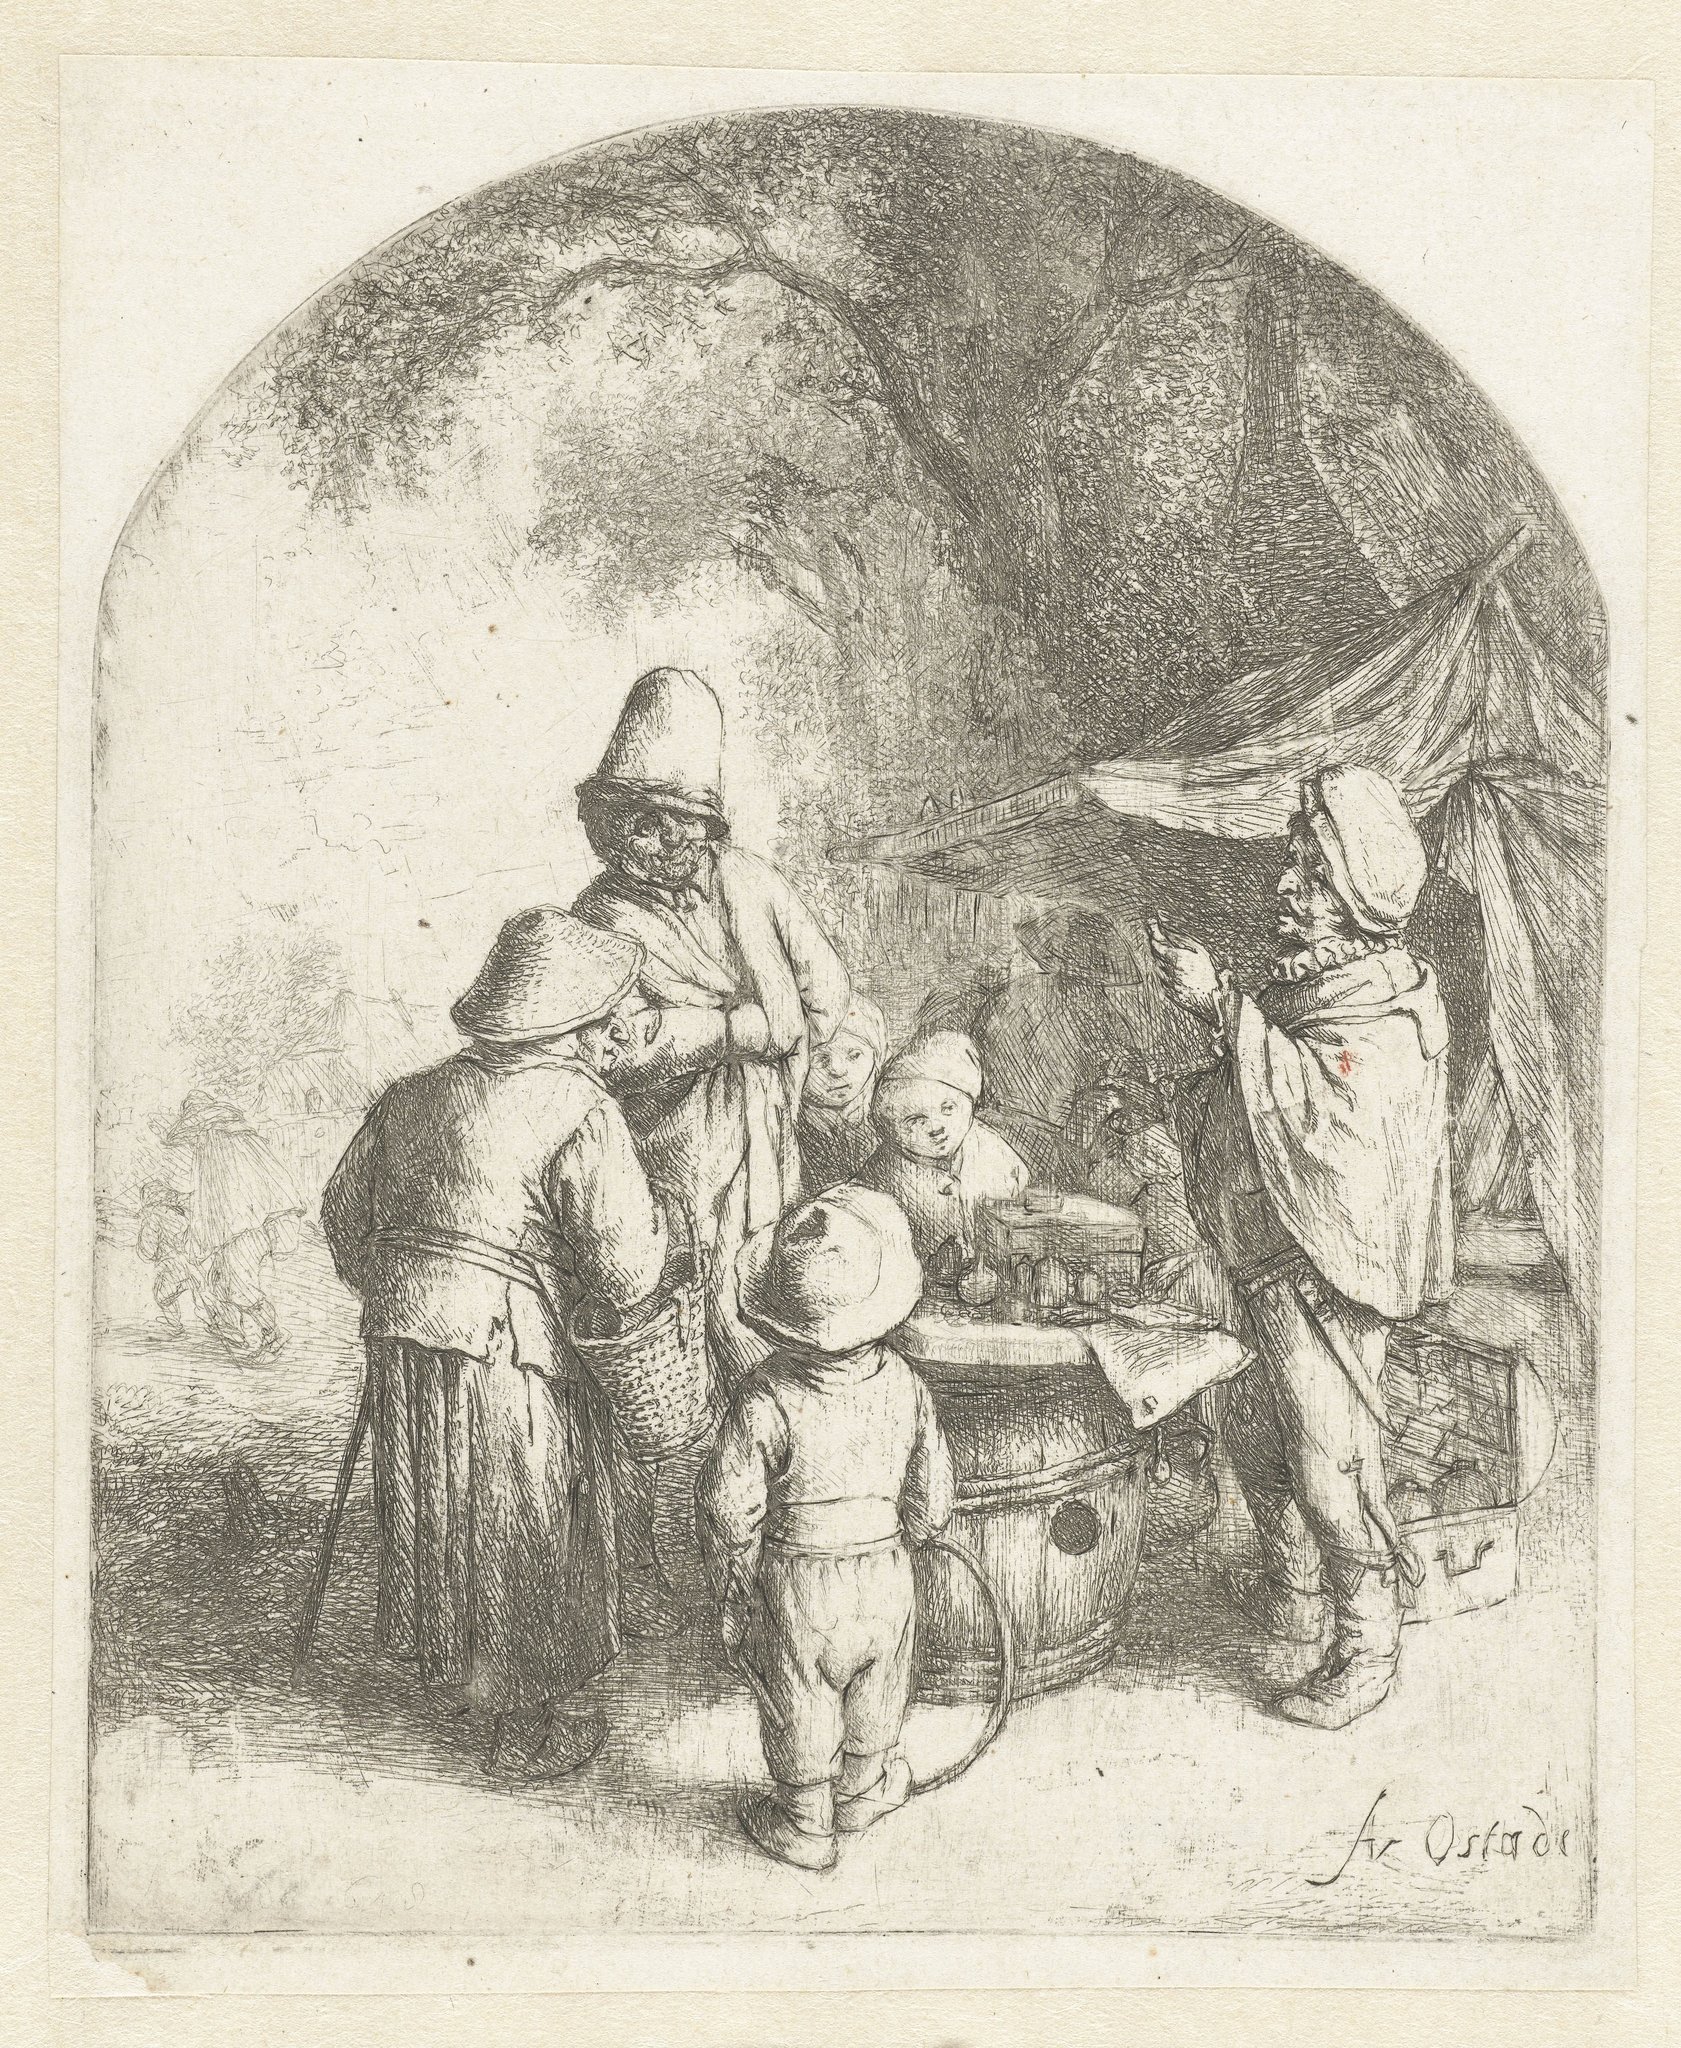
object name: print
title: Kwakzalver verkoopt zijn waren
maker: adriaen van ostade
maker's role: draughtsman, painter, print maker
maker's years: 1610-1685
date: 1648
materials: paper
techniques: etching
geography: haarlem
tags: quack, charlatan, mountebank, 'saltimbanco'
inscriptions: collector's mark: Lugt 240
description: Enkele volwassenen en kinderen luisteren naar het verhaal van een kwakzalver die zijn waren probeert te slijten vlakbij een grote boom en tent . Op de voorgrond staat een kleine jongen met een hoepel te kijken met de rug naar de beschouwer toe. De voorstelling heeft een halfronde bovenkant.